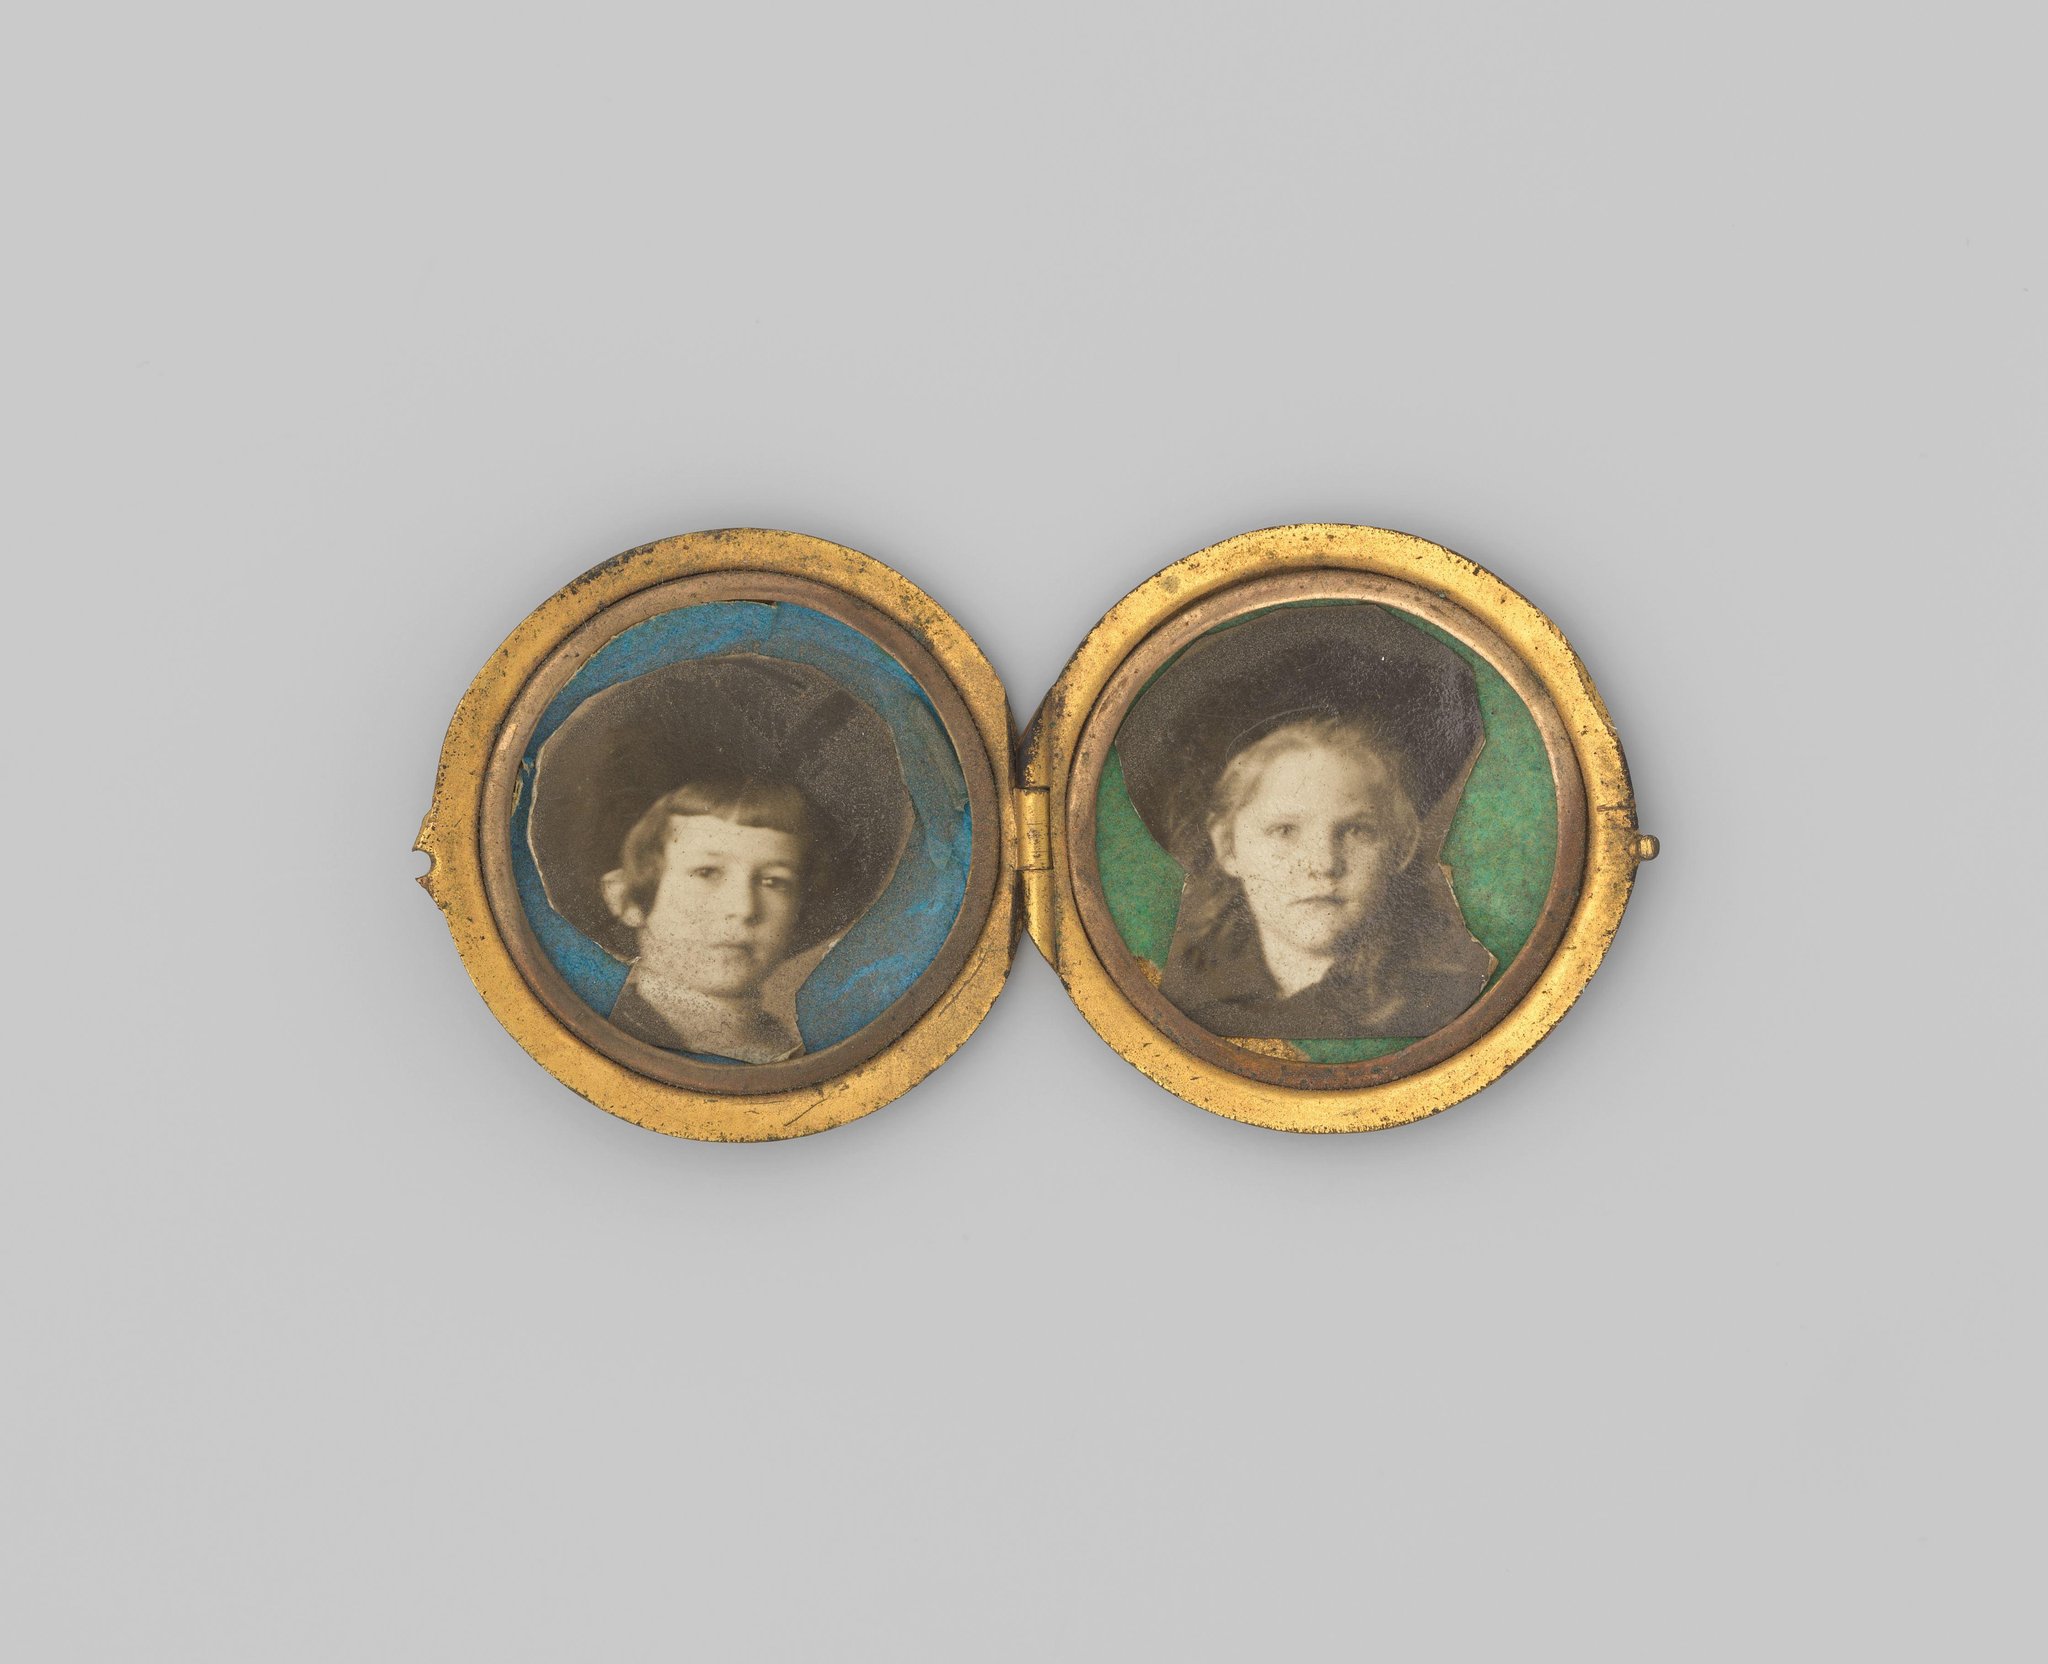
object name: photograph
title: Portret van een onbekende jongen met hoed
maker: Anonymous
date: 1880-1910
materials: paper, watercolor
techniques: brush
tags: boy (child between toddler and youth), historical persons, head-gear: hat